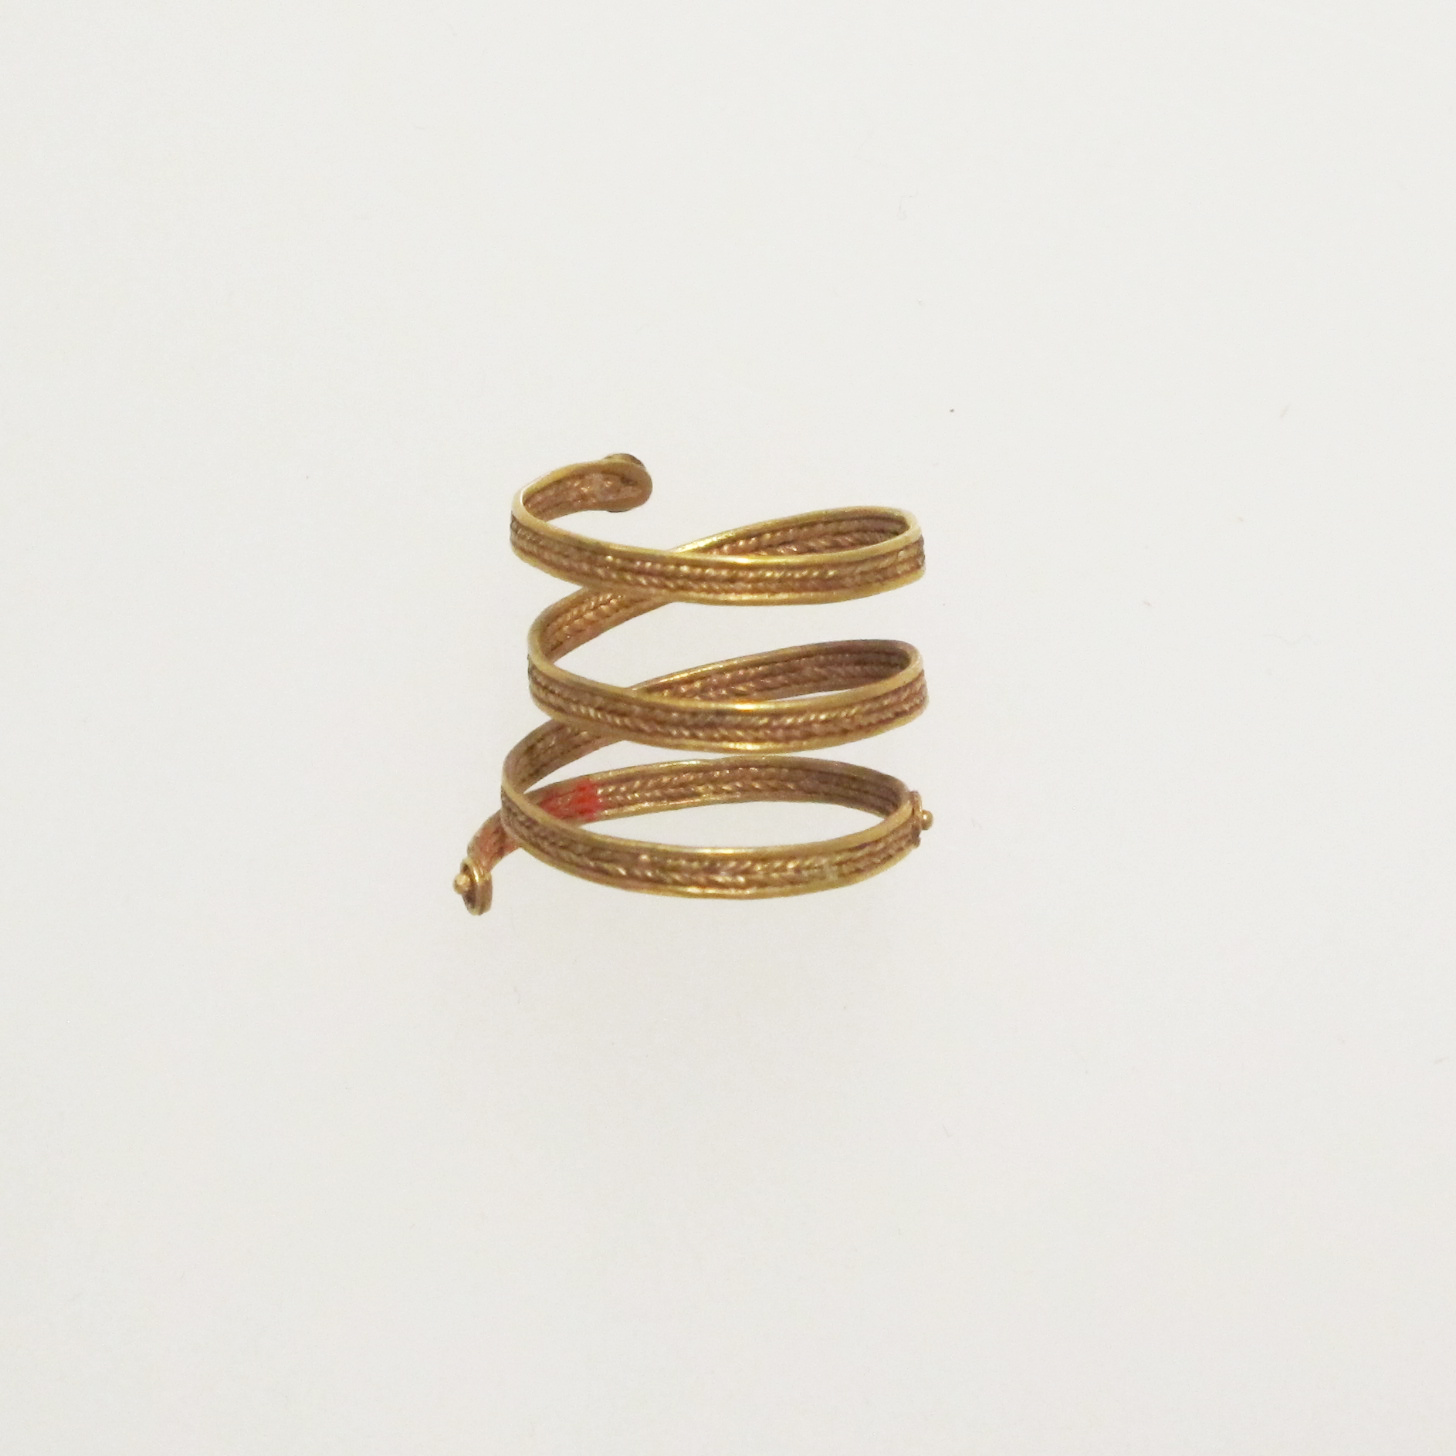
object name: hair spiral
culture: greek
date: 7000-30 BCE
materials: gold